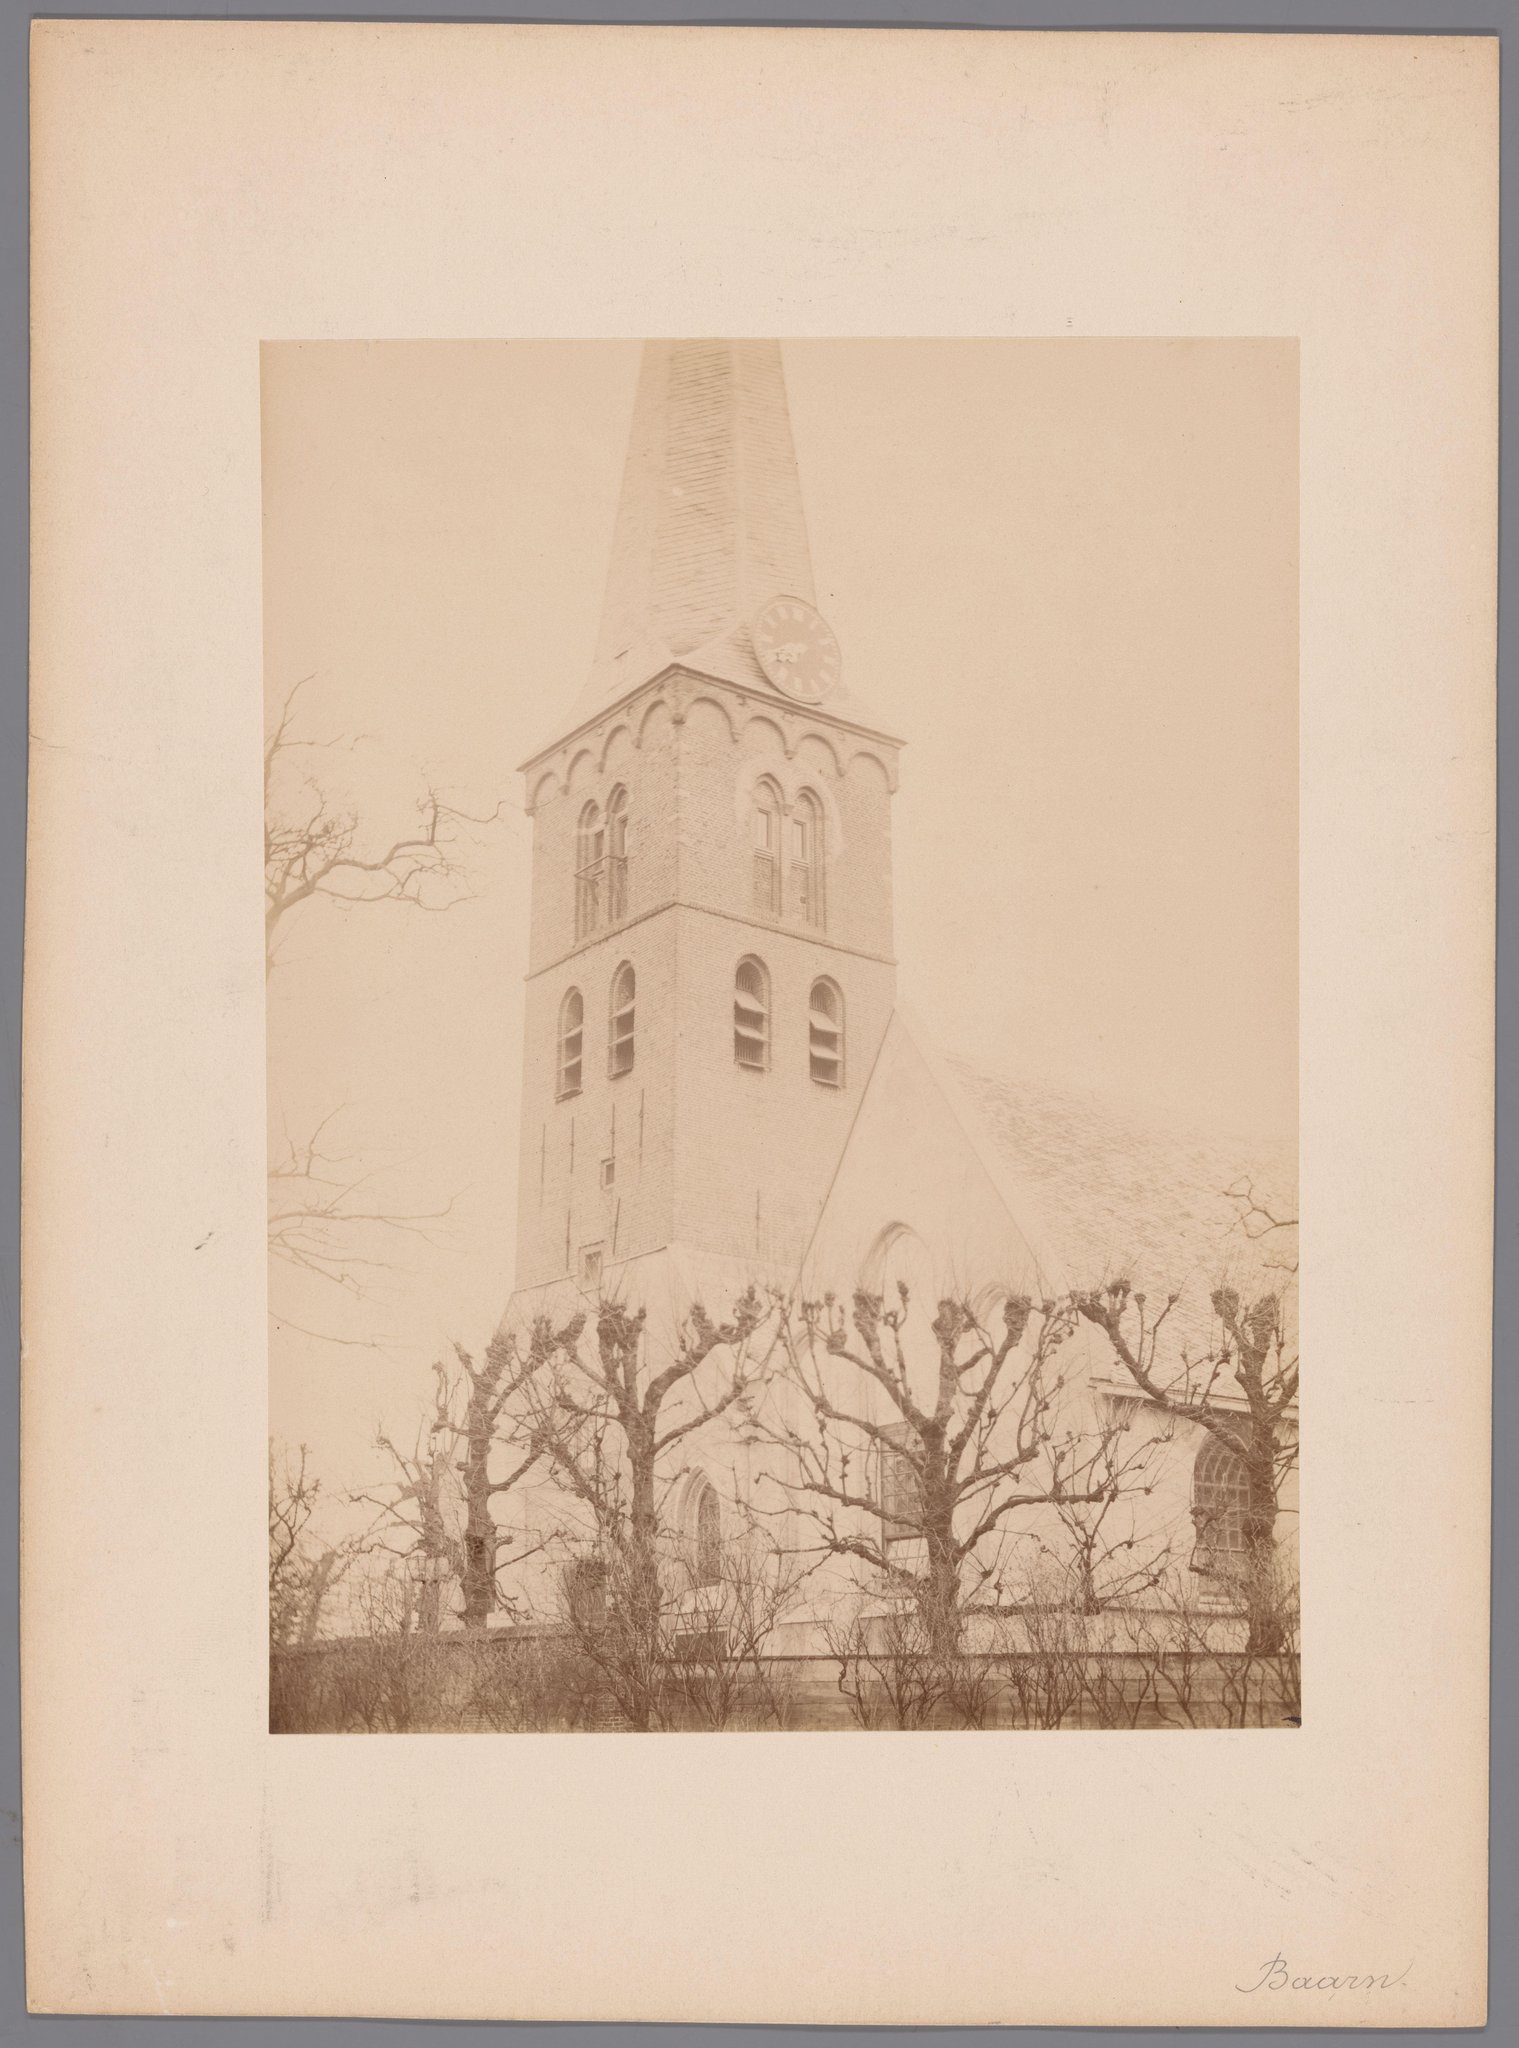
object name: photograph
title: Toren van de Pauluskerk te Baarn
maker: anoniem (monumentenzorg)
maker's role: fotograaf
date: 1890-1920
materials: cardboard, photographic support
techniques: albumen print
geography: baarn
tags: parts of church exterior and annexes: tower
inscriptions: annotation: ‘Baarn’, annotation: ‘Baarn/ N.H. Kerk’